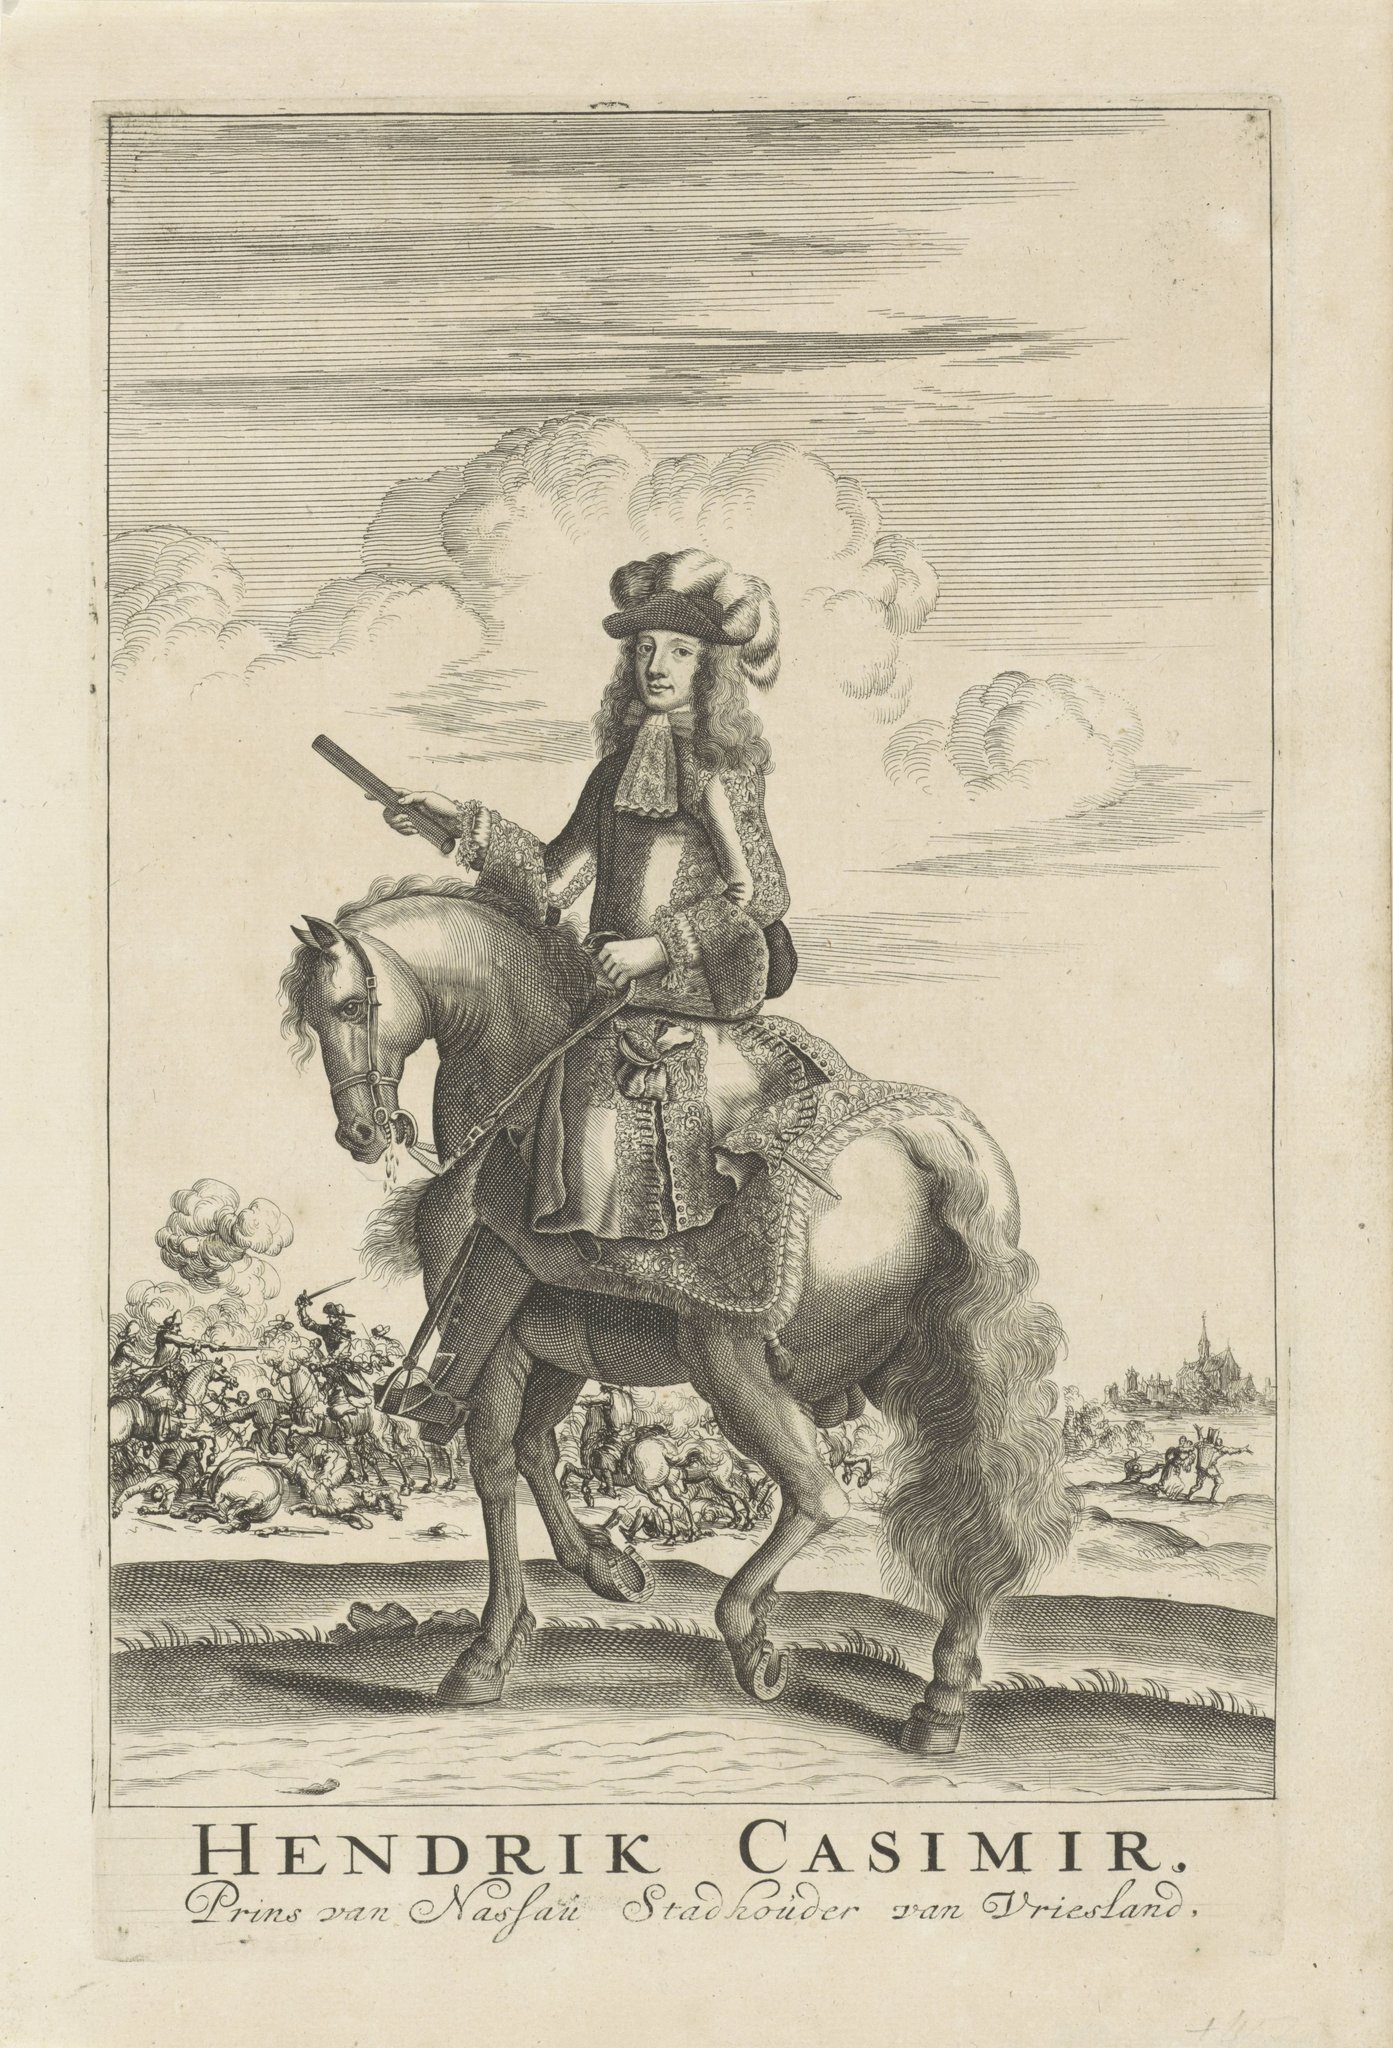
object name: print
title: Ruiterportret van Hendrik Casimir II, graaf van Nassau-Dietz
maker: Anonymous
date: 1675-1749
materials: paper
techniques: engraving, etching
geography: low countries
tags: hendrik casimir ii graaf van nassau-dietz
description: De hier vermelde titel verwijst naar de hoogst verkregen titel van de geportretteerde, niet per se naar de titel die de geportretteerde op deze voorstelling draagt.